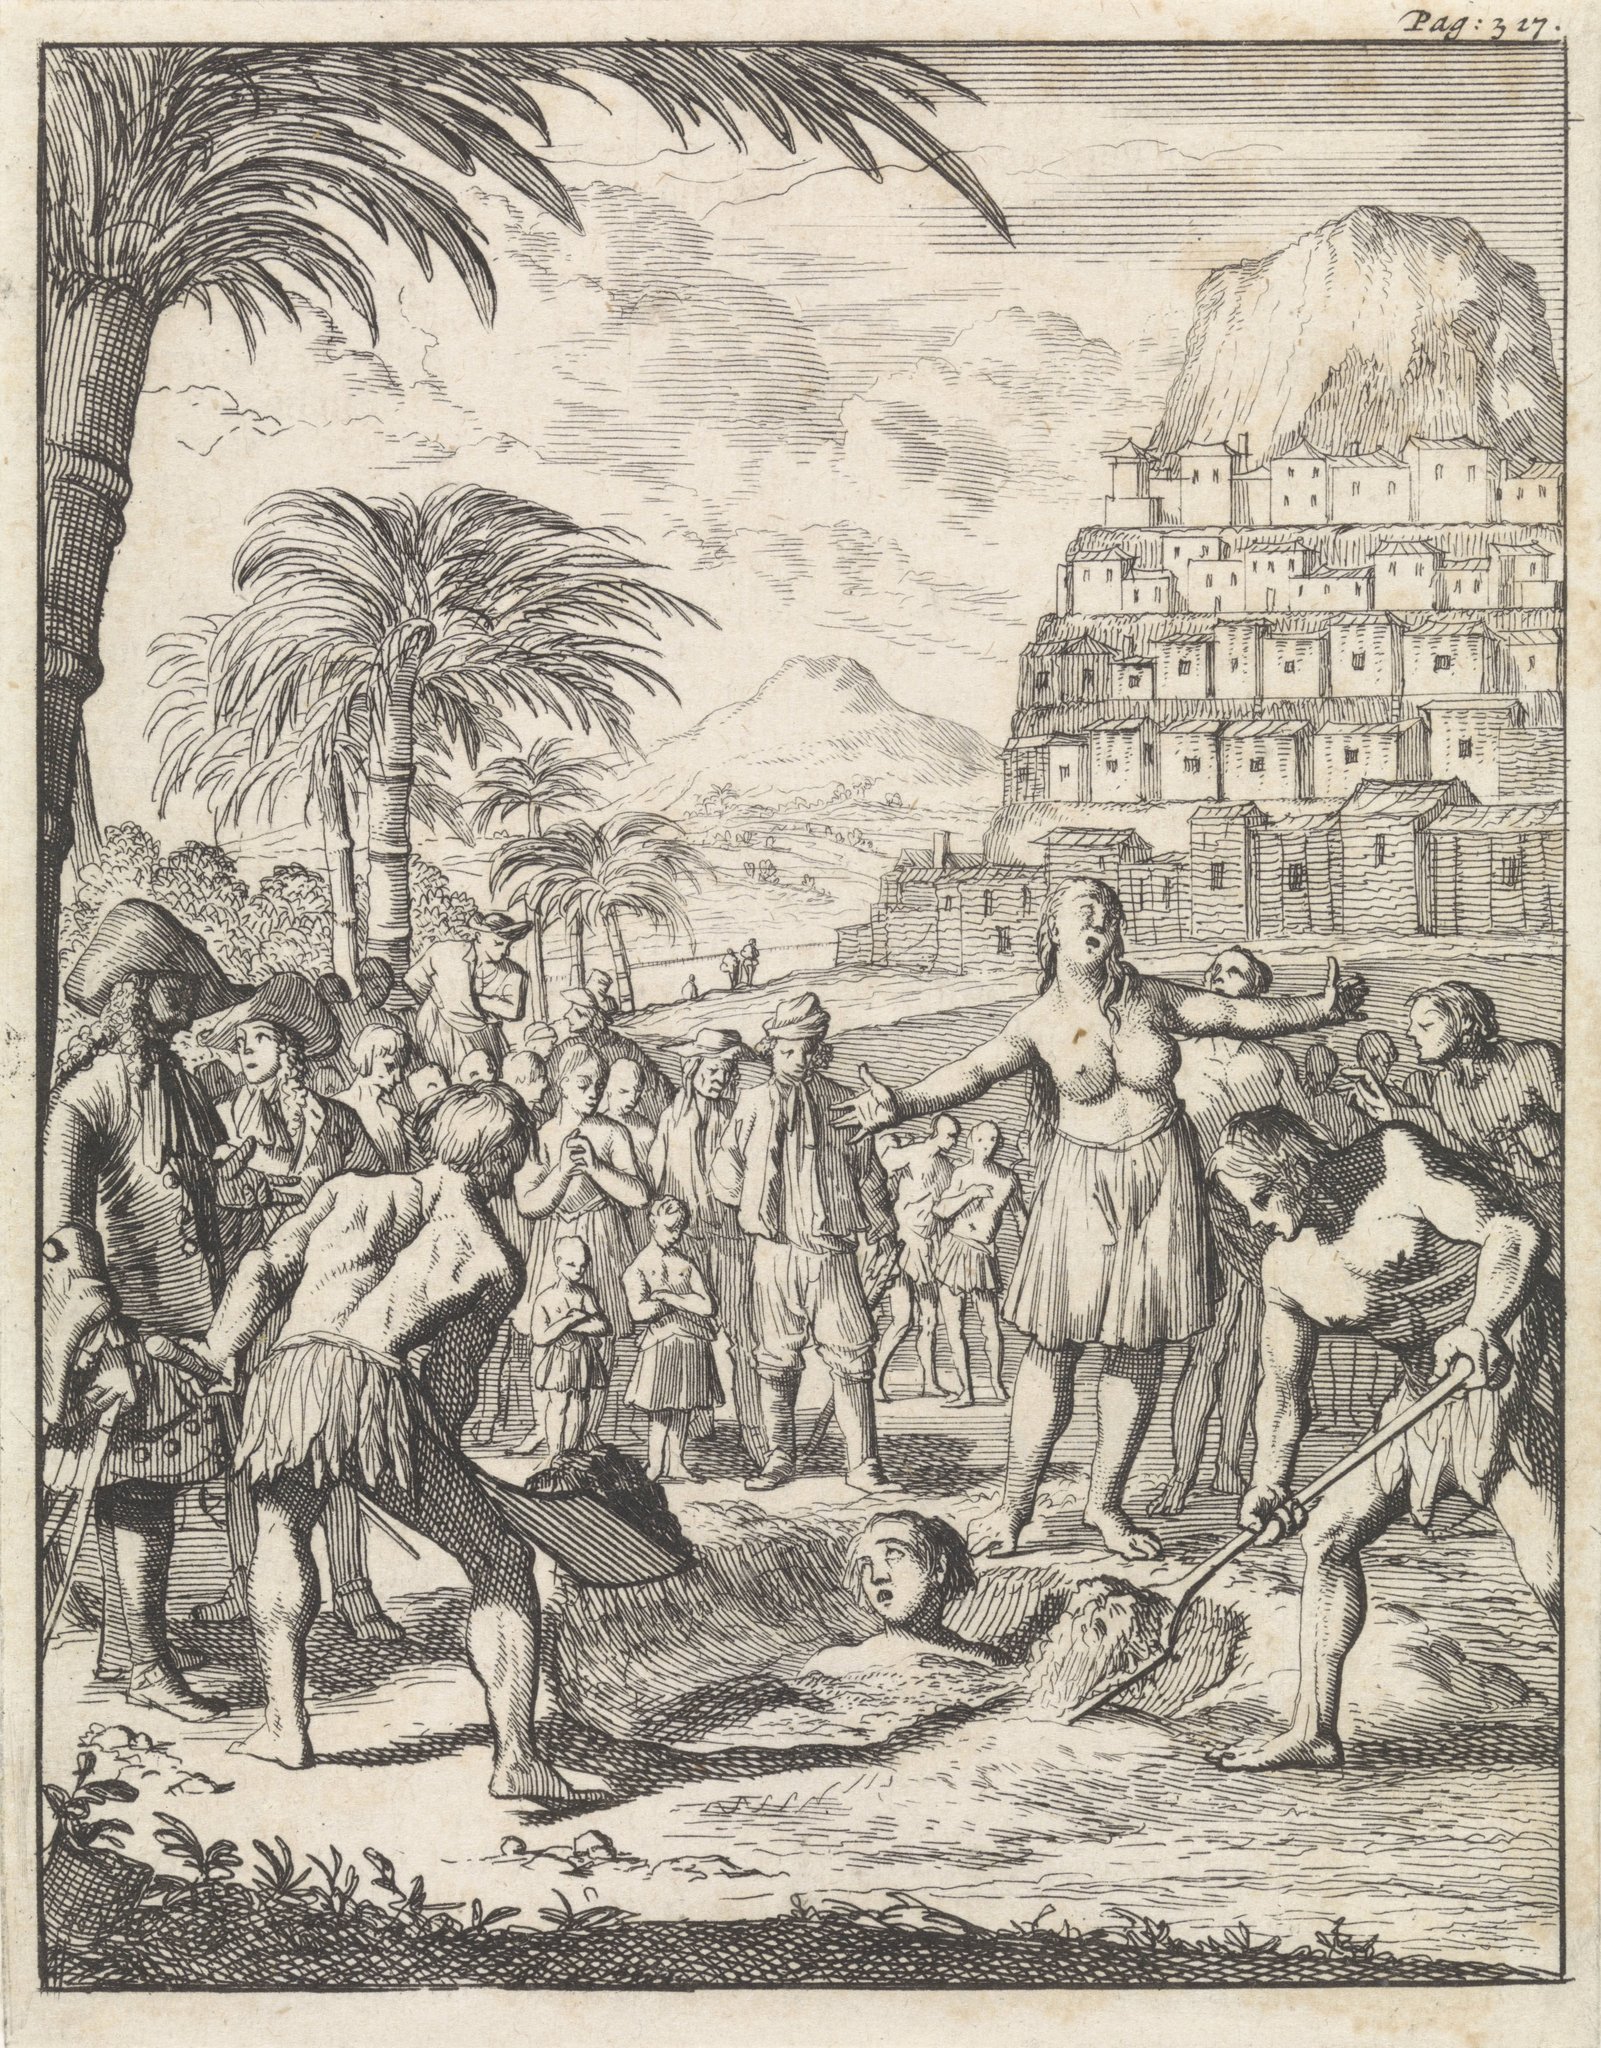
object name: print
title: Op het eiland Formosa wordt een man als straf voor diefstal levend begraven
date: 1698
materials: paper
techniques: etching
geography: the hague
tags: buried alive (violent death), formosa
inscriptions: collector's mark: Lugt 2228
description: Illustratie uit: Dampier, William. Nieuwe reystogt rondom de werreld, 3 delen (1698-1704). Den Haag: Abraham de Hondt, 1698, dl. I, p. 317.